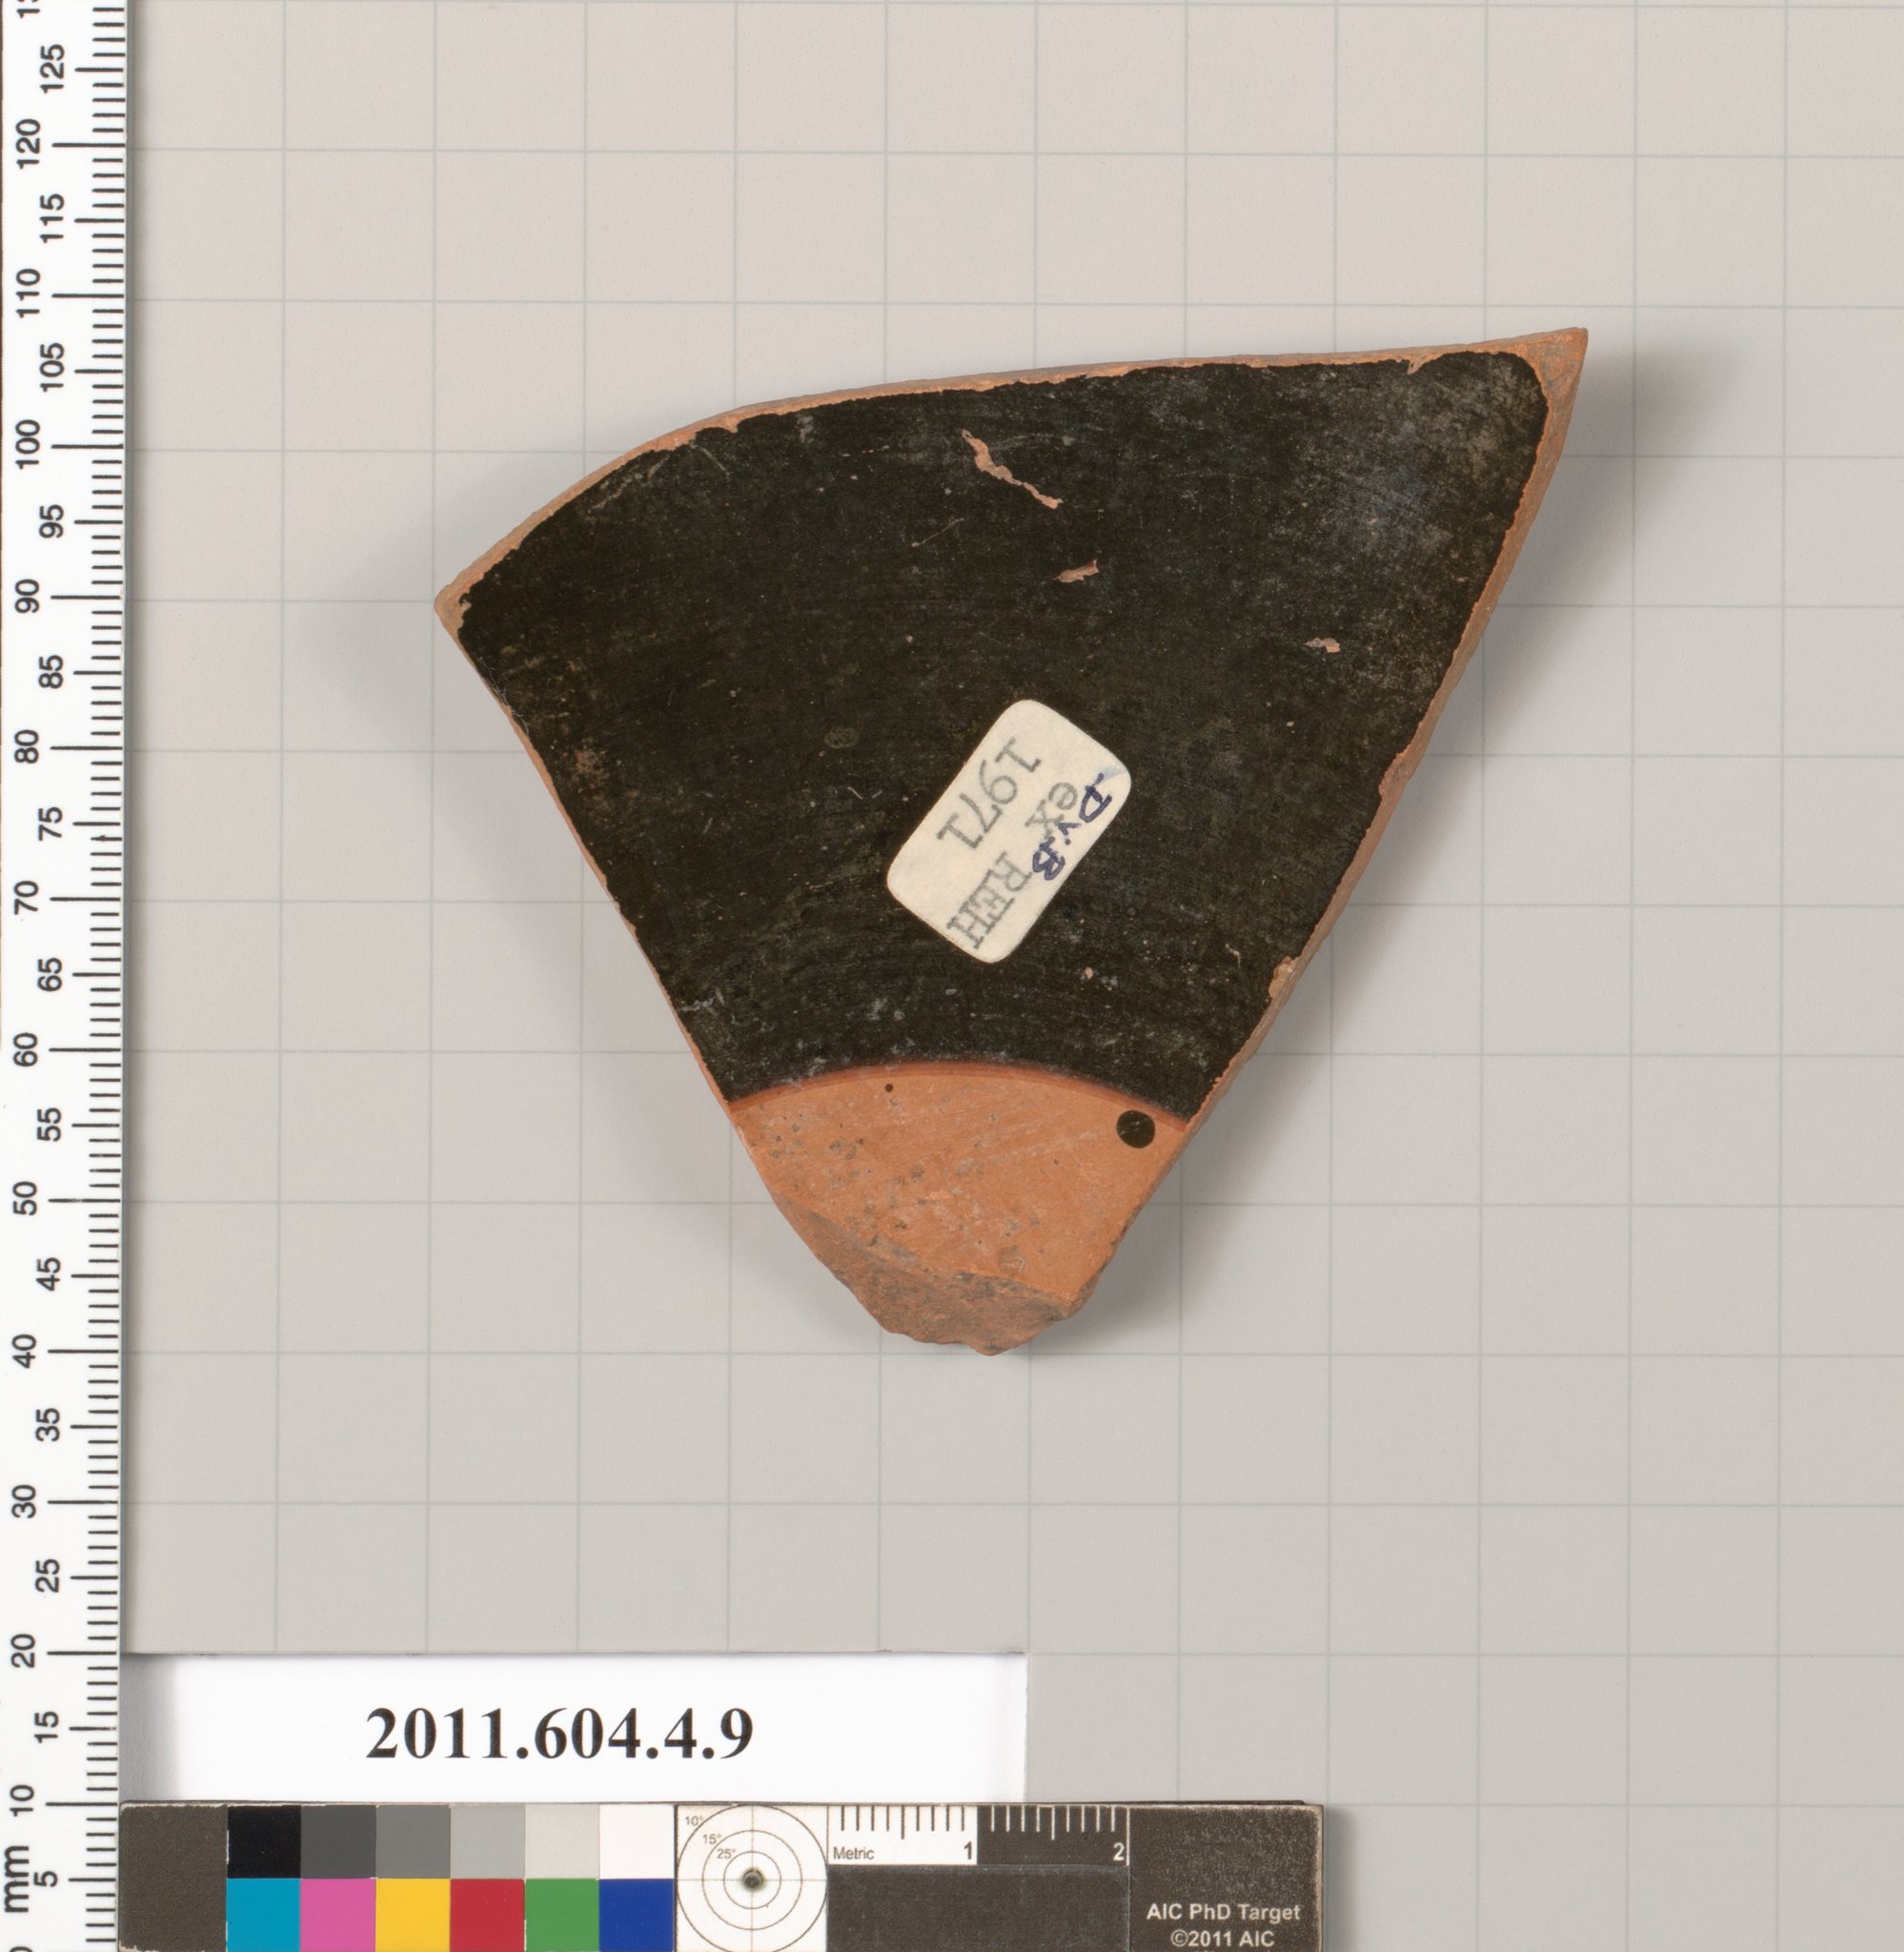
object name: kylix fragment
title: Terracotta fragment of a kylix: band-cup (drinking cup)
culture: greek, attic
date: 550-526 BCE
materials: terracotta